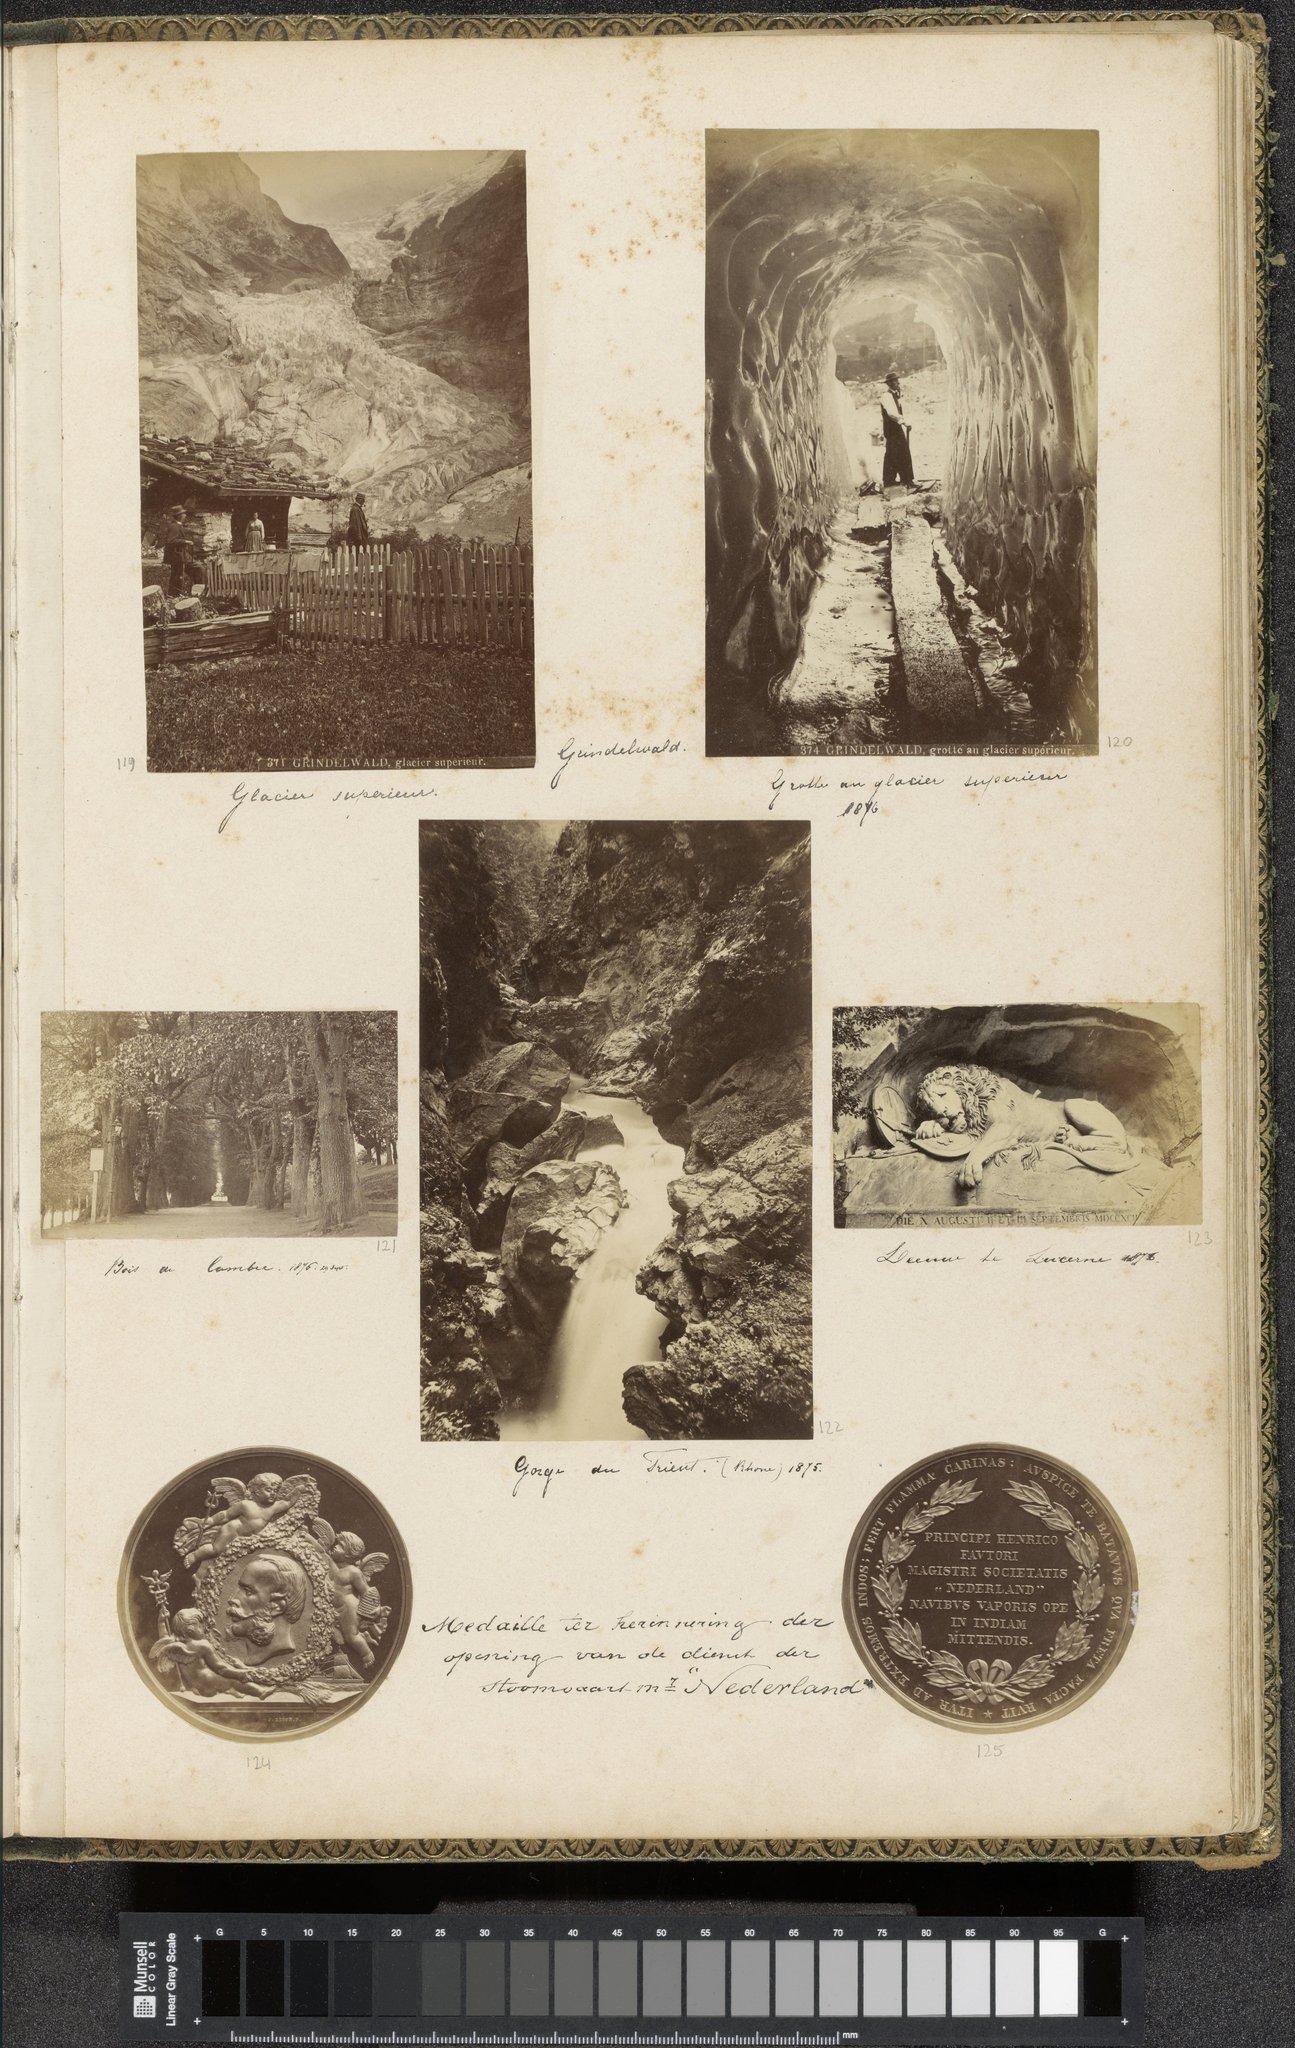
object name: photograph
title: Fotoreproductie van een penning met Latijnse tekst, geslagen ter gelegenheid van de oprichting van de Stoomvaart Maatschappij Nederland (achterzijde)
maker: Anonymous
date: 1874-1880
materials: paper, photographic support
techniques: albumen print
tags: memorial medal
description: Onderdeel van Fotoalbum van Robert Daniel Crommelin (1841-1907).